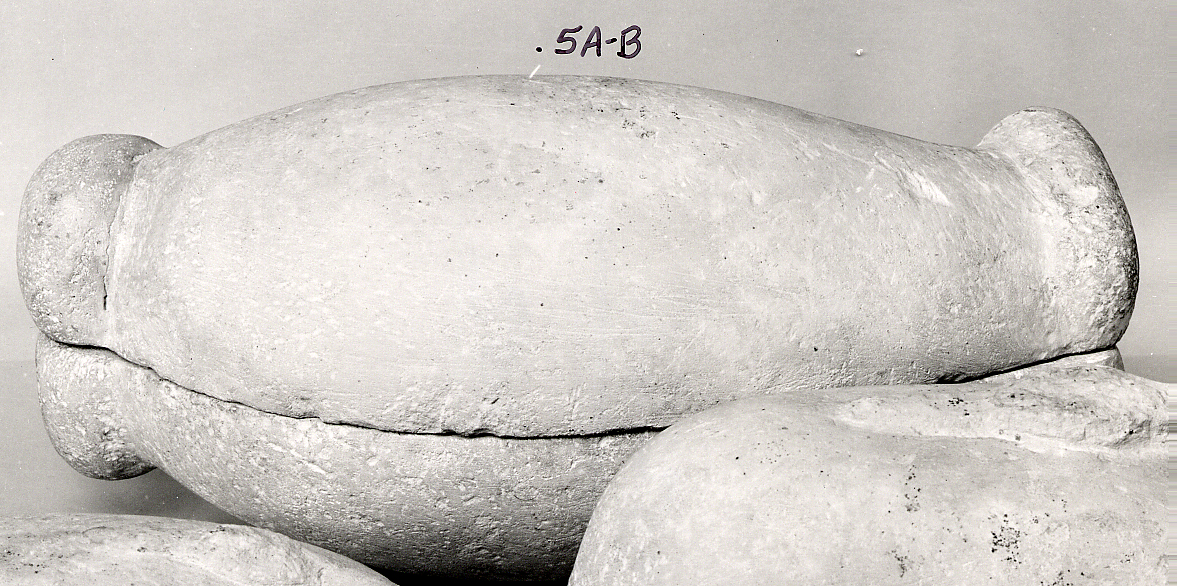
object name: mummified leg of beef case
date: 2323-2255 BCE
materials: limestone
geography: egypt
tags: food